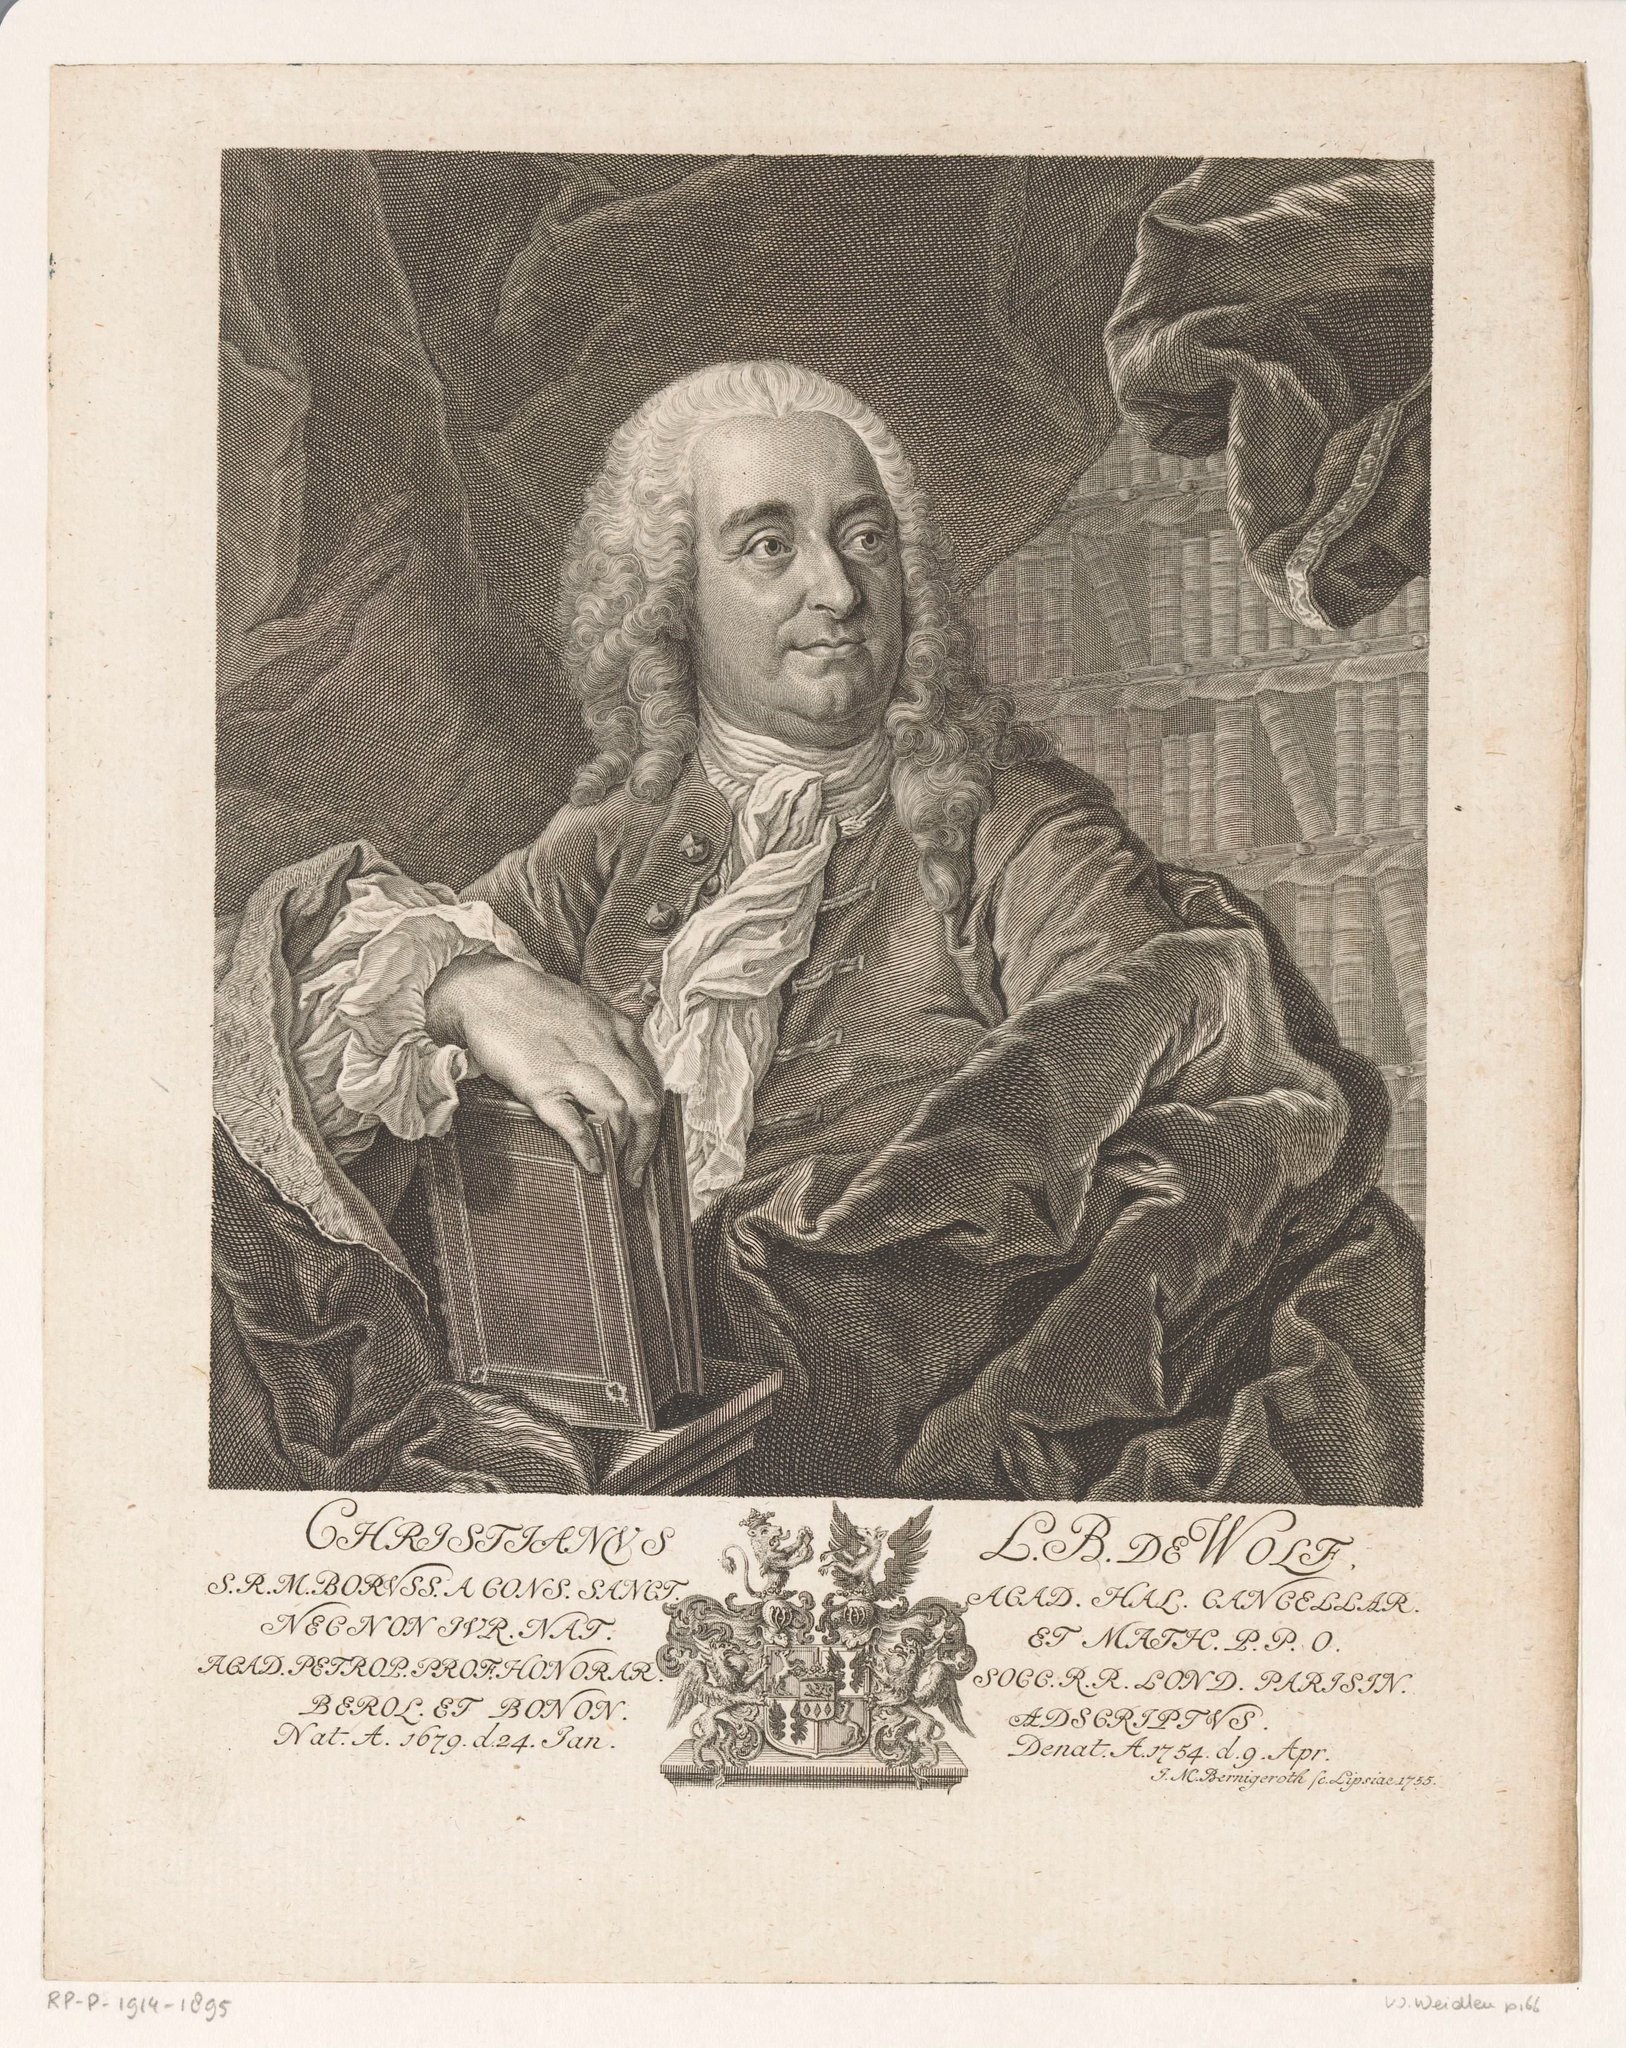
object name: print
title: Portret van Christian Wolff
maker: johann martin bernigeroth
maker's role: print maker, publisher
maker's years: 1713-1767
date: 1755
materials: paper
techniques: engraving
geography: leipzig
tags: bookshelves, historical persons, book, armorial bearing, heraldry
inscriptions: collector's mark: Lugt 2228